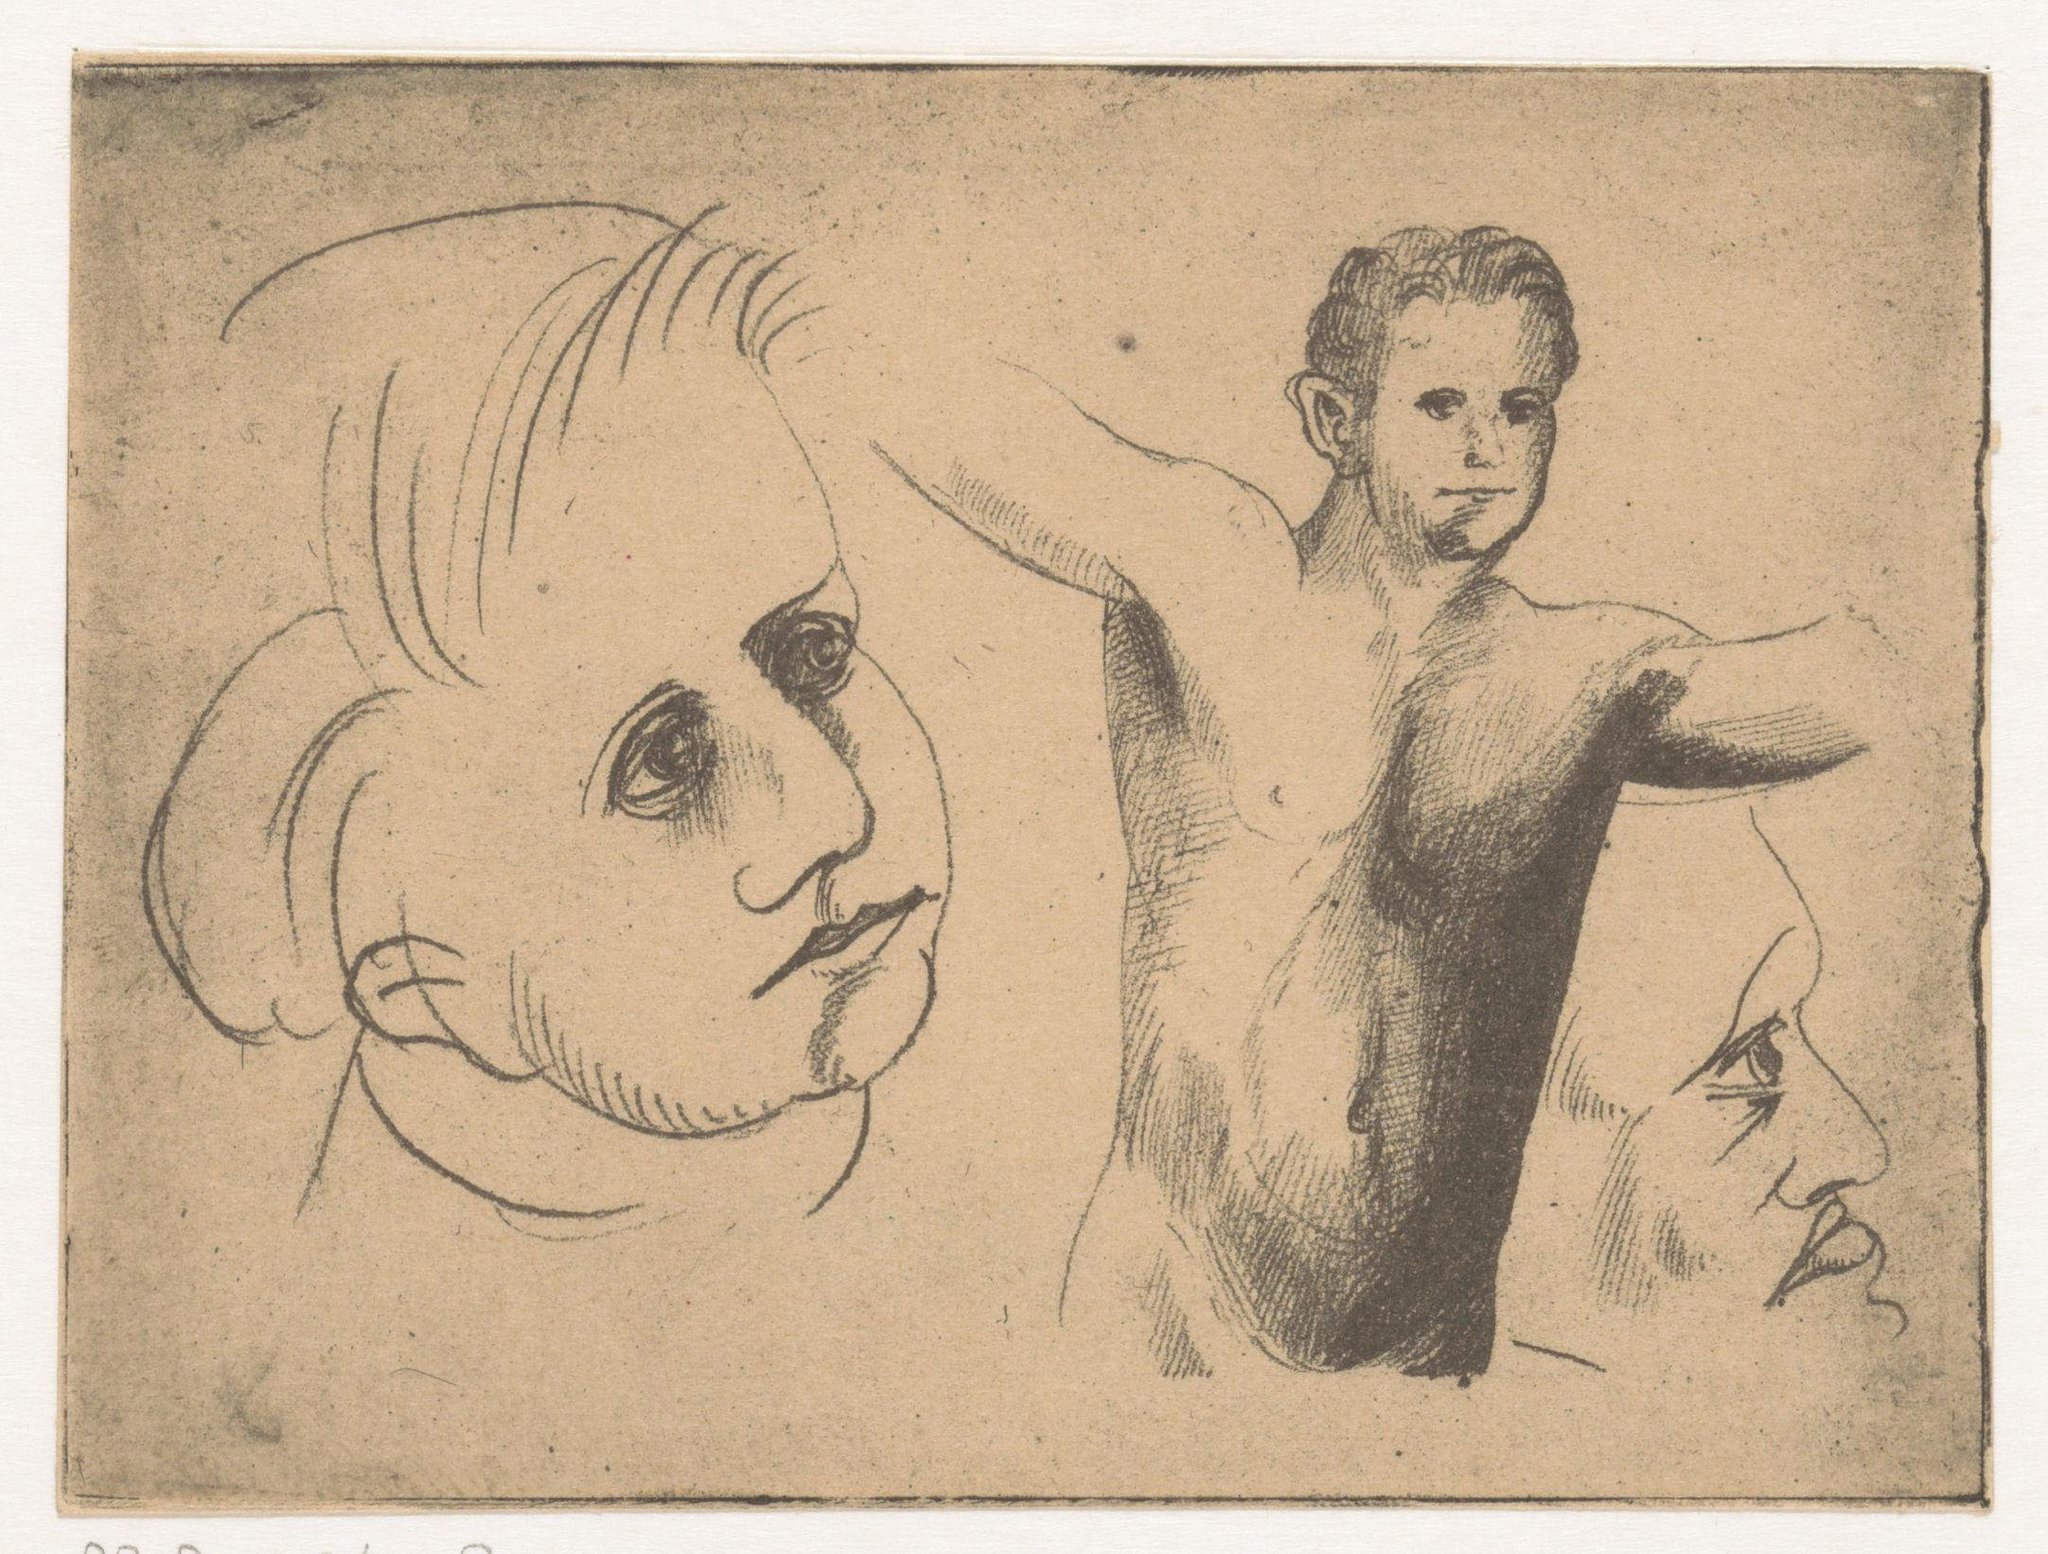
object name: print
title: Studie van twee hoofden en een jonge man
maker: marius holleman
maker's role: draughtsman, print maker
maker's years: 1878-1926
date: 1904-1926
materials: paper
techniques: etching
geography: groningen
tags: youth, adolescent, man (showing himself) undressed, quasi-nude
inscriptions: collector's mark: Lugt 2228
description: Links het hoofd van een kind. Rechts een halfnaakte jonge man met de armen omhoog. Rechtsonder een hoofd en profil.